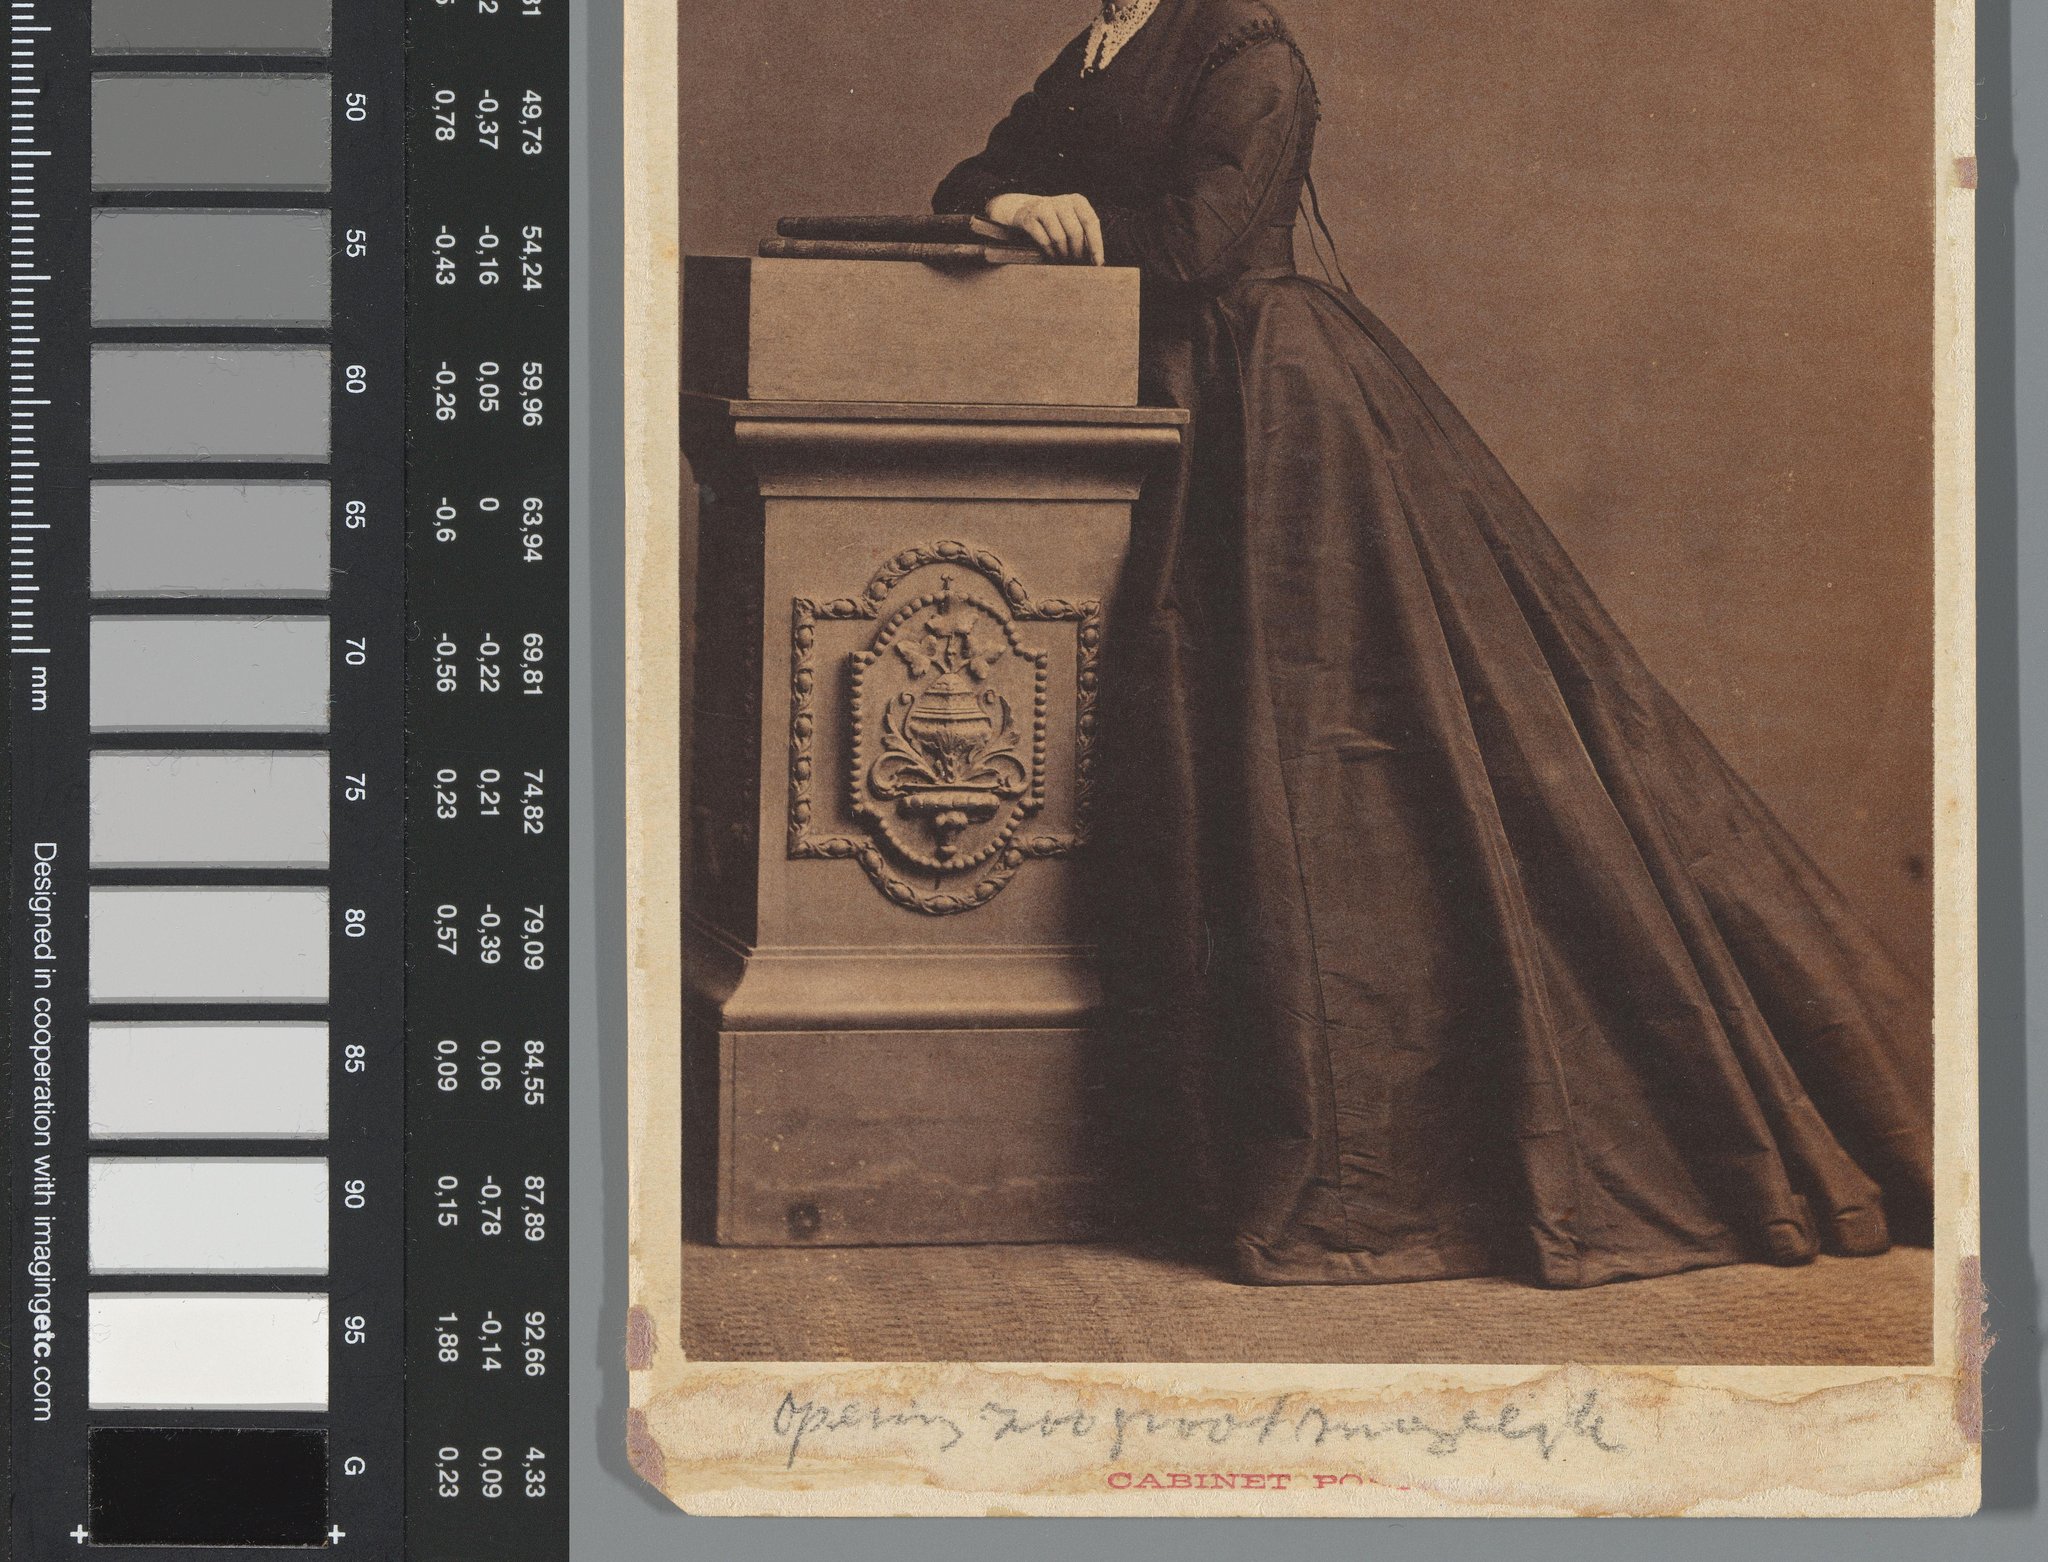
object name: cabinet photograph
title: Studioportret van Carolina Frederika Holle staand, leunend op een sokkel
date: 1868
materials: cardboard, photographic support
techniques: albumen print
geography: java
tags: amsterdam, carolina frederika van den berg-holle, batavia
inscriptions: name: ‘C.F. van den Berg-Holle’, inscription: ‘Batavia / 1868’, inscription: ‘opening zoo groot mogelijk’, inscription: ‘CABINET ...’, inscription: ‘C F van den Berg-Holle / arolina / 1840 - 1909’, name: ‘WOODBURY & PAGE , / JAVA.’